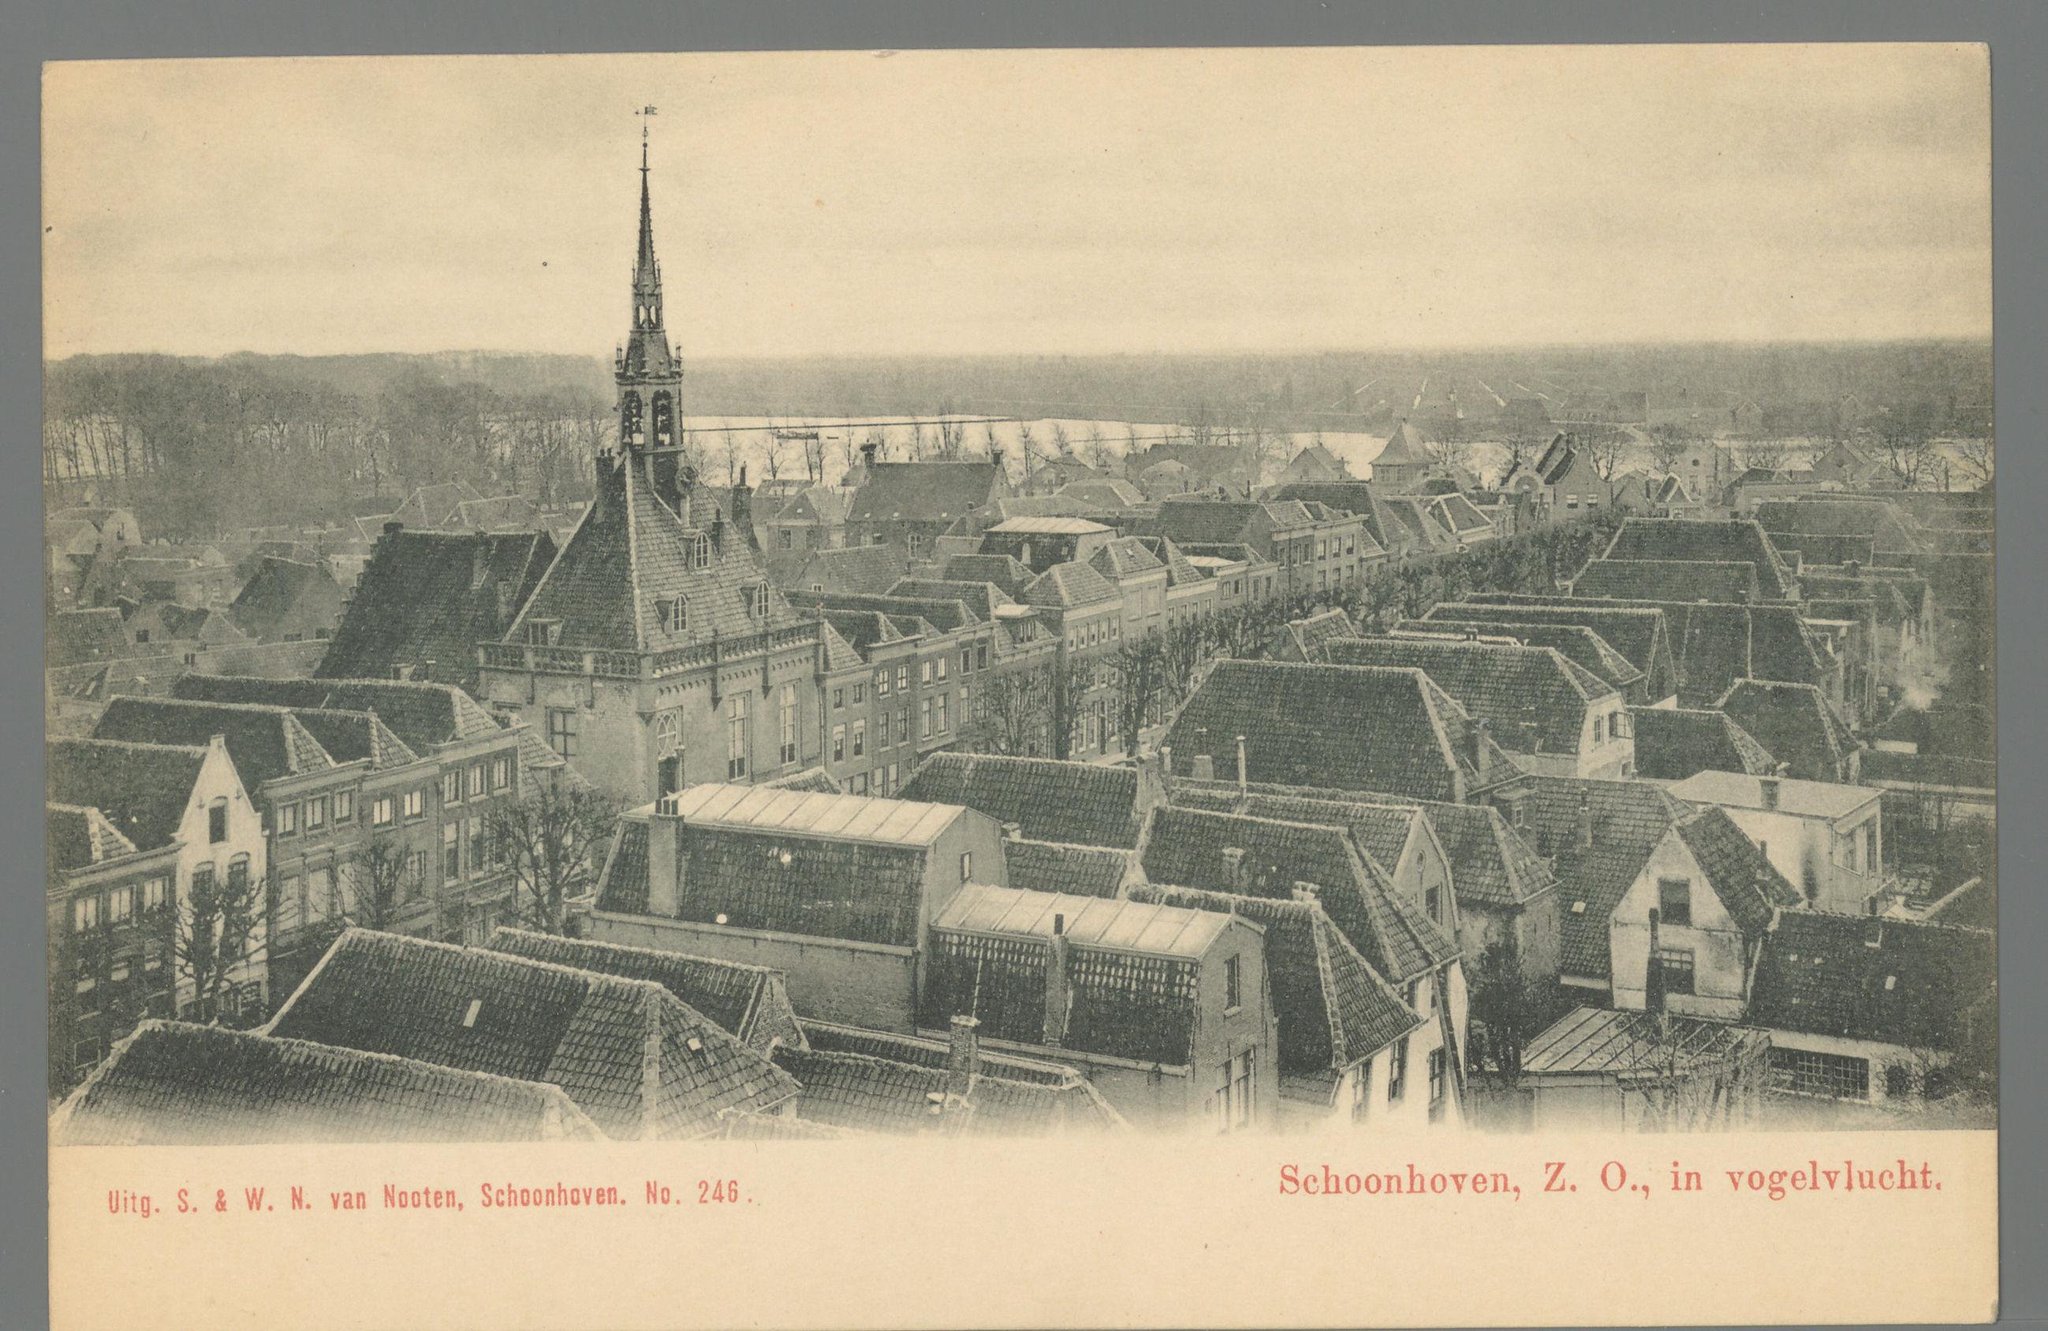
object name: photomechanical print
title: Schoonhoven, Z. O., in vogelvlucht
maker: Anonymous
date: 1897-1905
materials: cardboard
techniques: photograph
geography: schoonhoven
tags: townhall, prospect of city, town panorama, silhouette of city